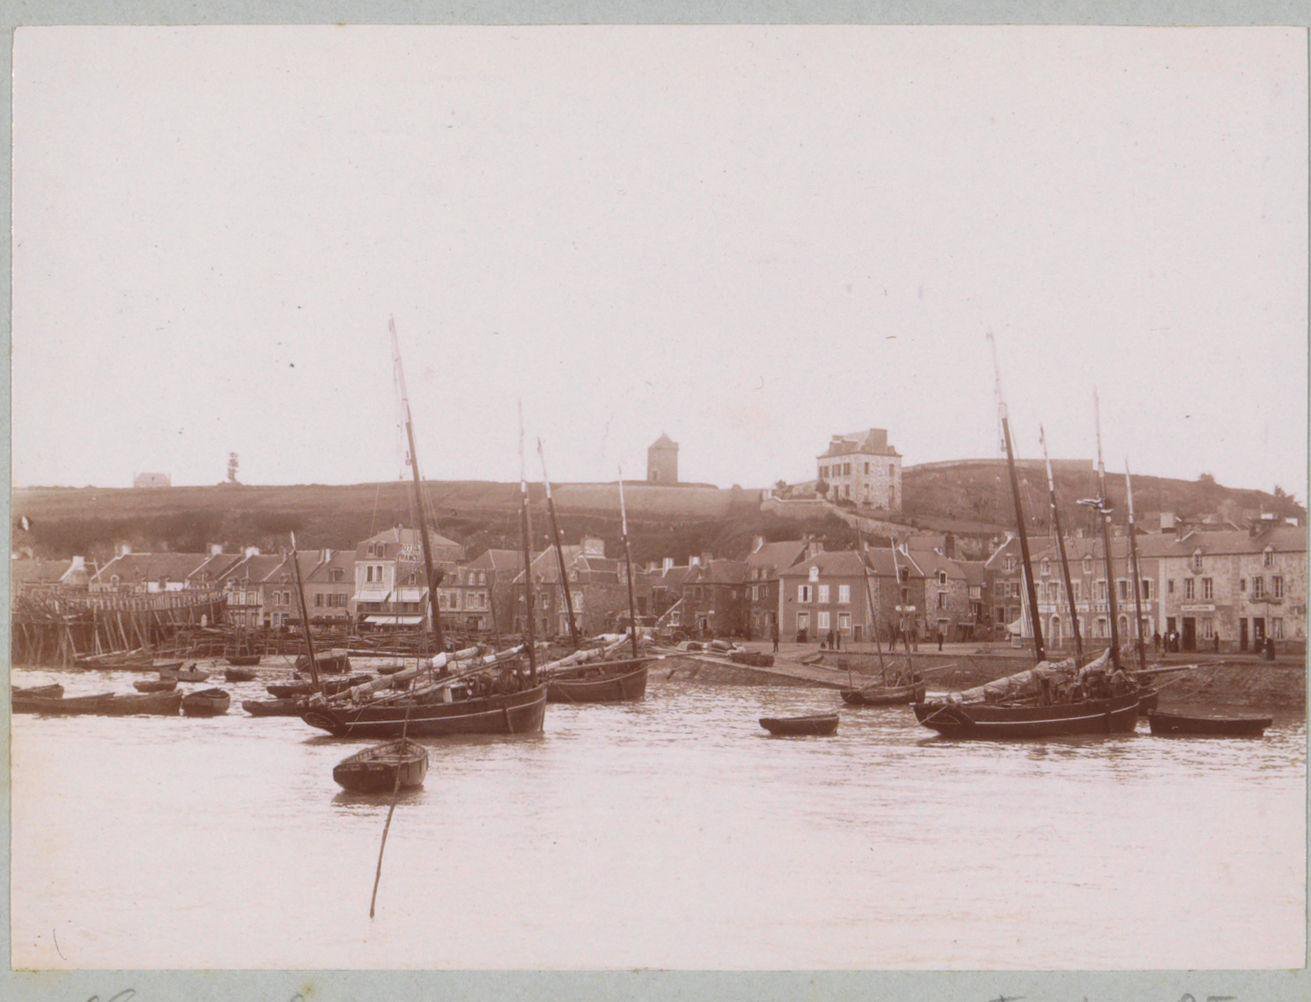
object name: photograph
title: Gezicht op Cancale en de haven vanaf zee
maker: delizy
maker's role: manufacturer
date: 1896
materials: paper, photographic support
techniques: gelatin silver print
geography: cancale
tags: prospect of village, silhouette of village, harbour (+ view ~ vehicle, ship, etc.)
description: Onderdeel van Fotoalbum van een Franse amateurfotograaf met opnames van uitstapjes in Frankrijk, Spanje, België, Luxemburg en Nederland, de eerste automobielen en autoraces.